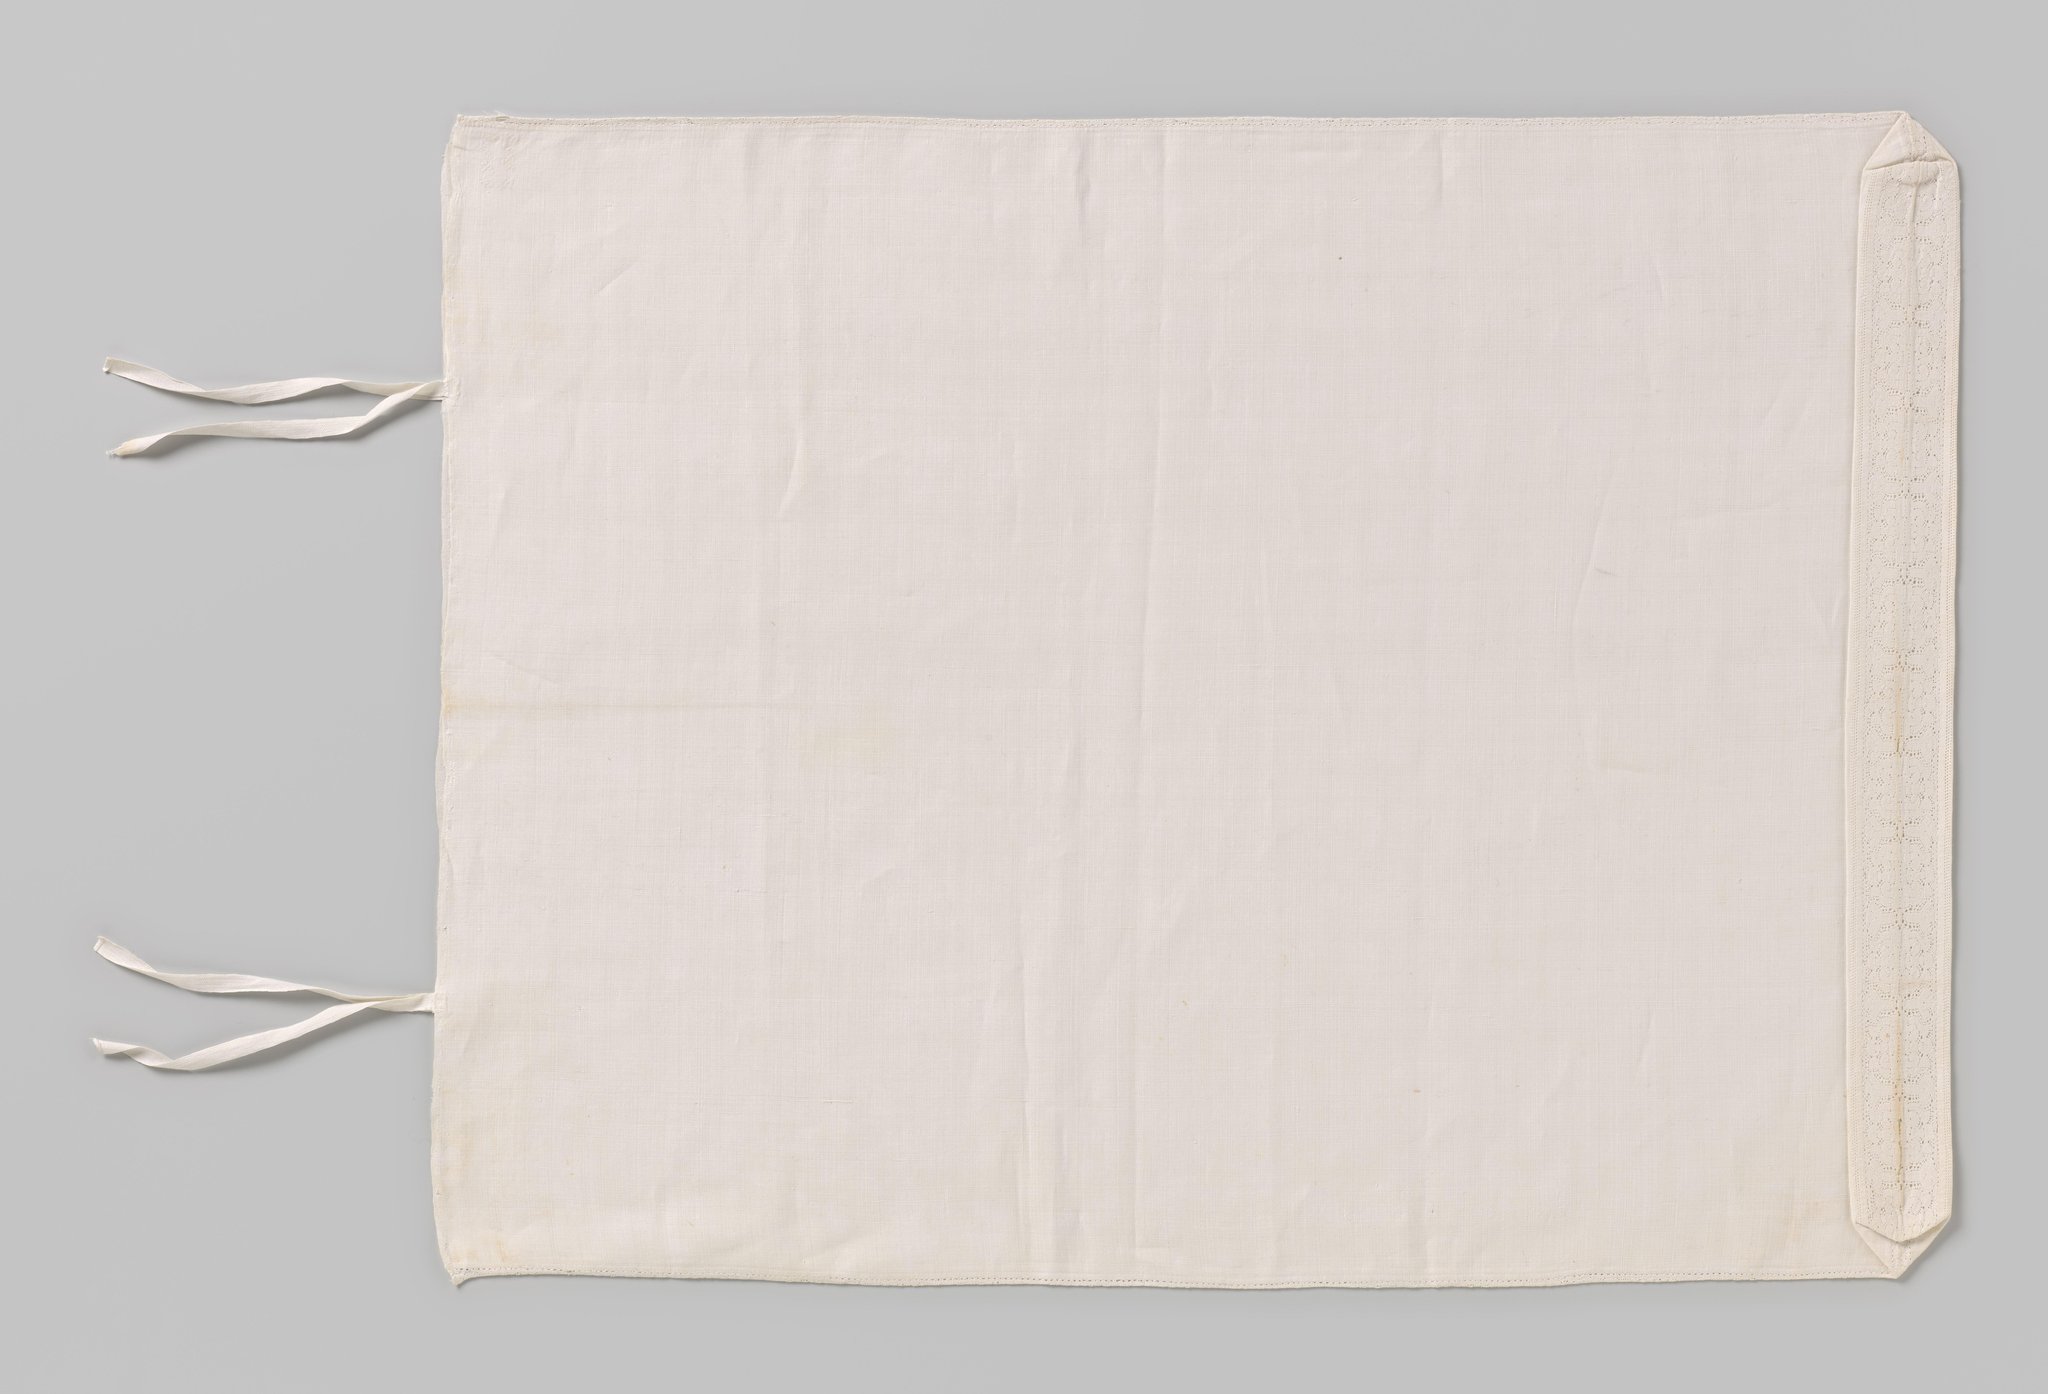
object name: pillowcase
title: Kussensloop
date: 1663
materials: linen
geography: northern netherlands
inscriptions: date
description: Kussensloop van linnen met Hollandse kant aan drie zijden. Gemerkt kroon LVK 1663.